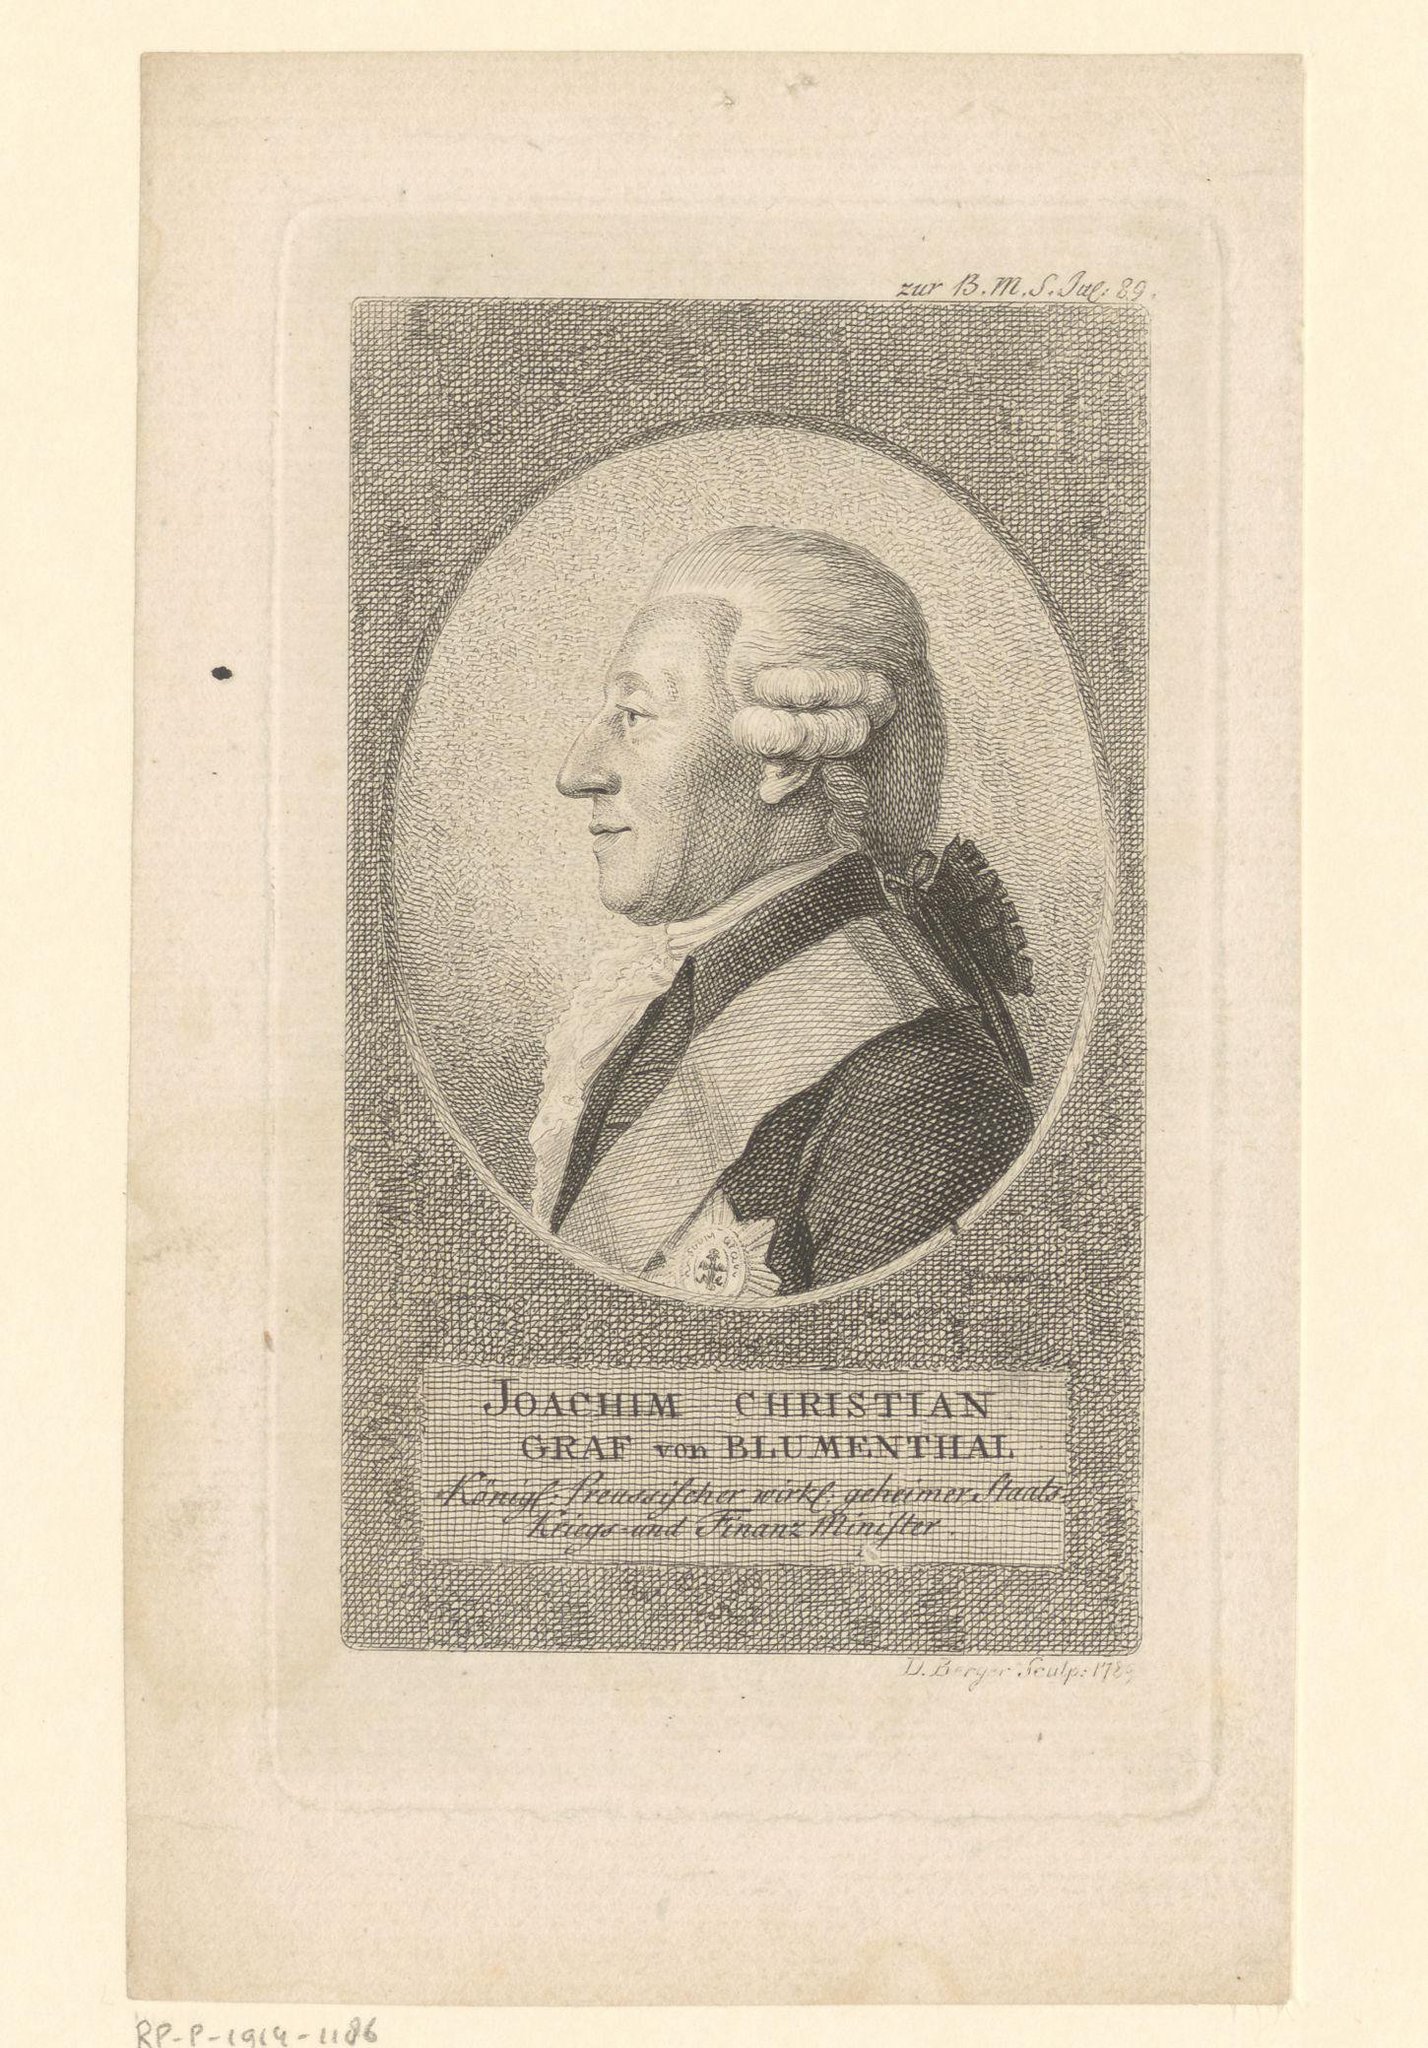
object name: print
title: Portret van Joachim Christian von Blumenthal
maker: daniel berger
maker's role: print maker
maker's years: 1744-1824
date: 1789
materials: paper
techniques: etching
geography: berlin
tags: historical persons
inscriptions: collector's mark: Lugt 2228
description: Prent afkomstig uit: Berlinische Monatsschrift. dl. 14. Berlijn: Haude & Spener, 1789.